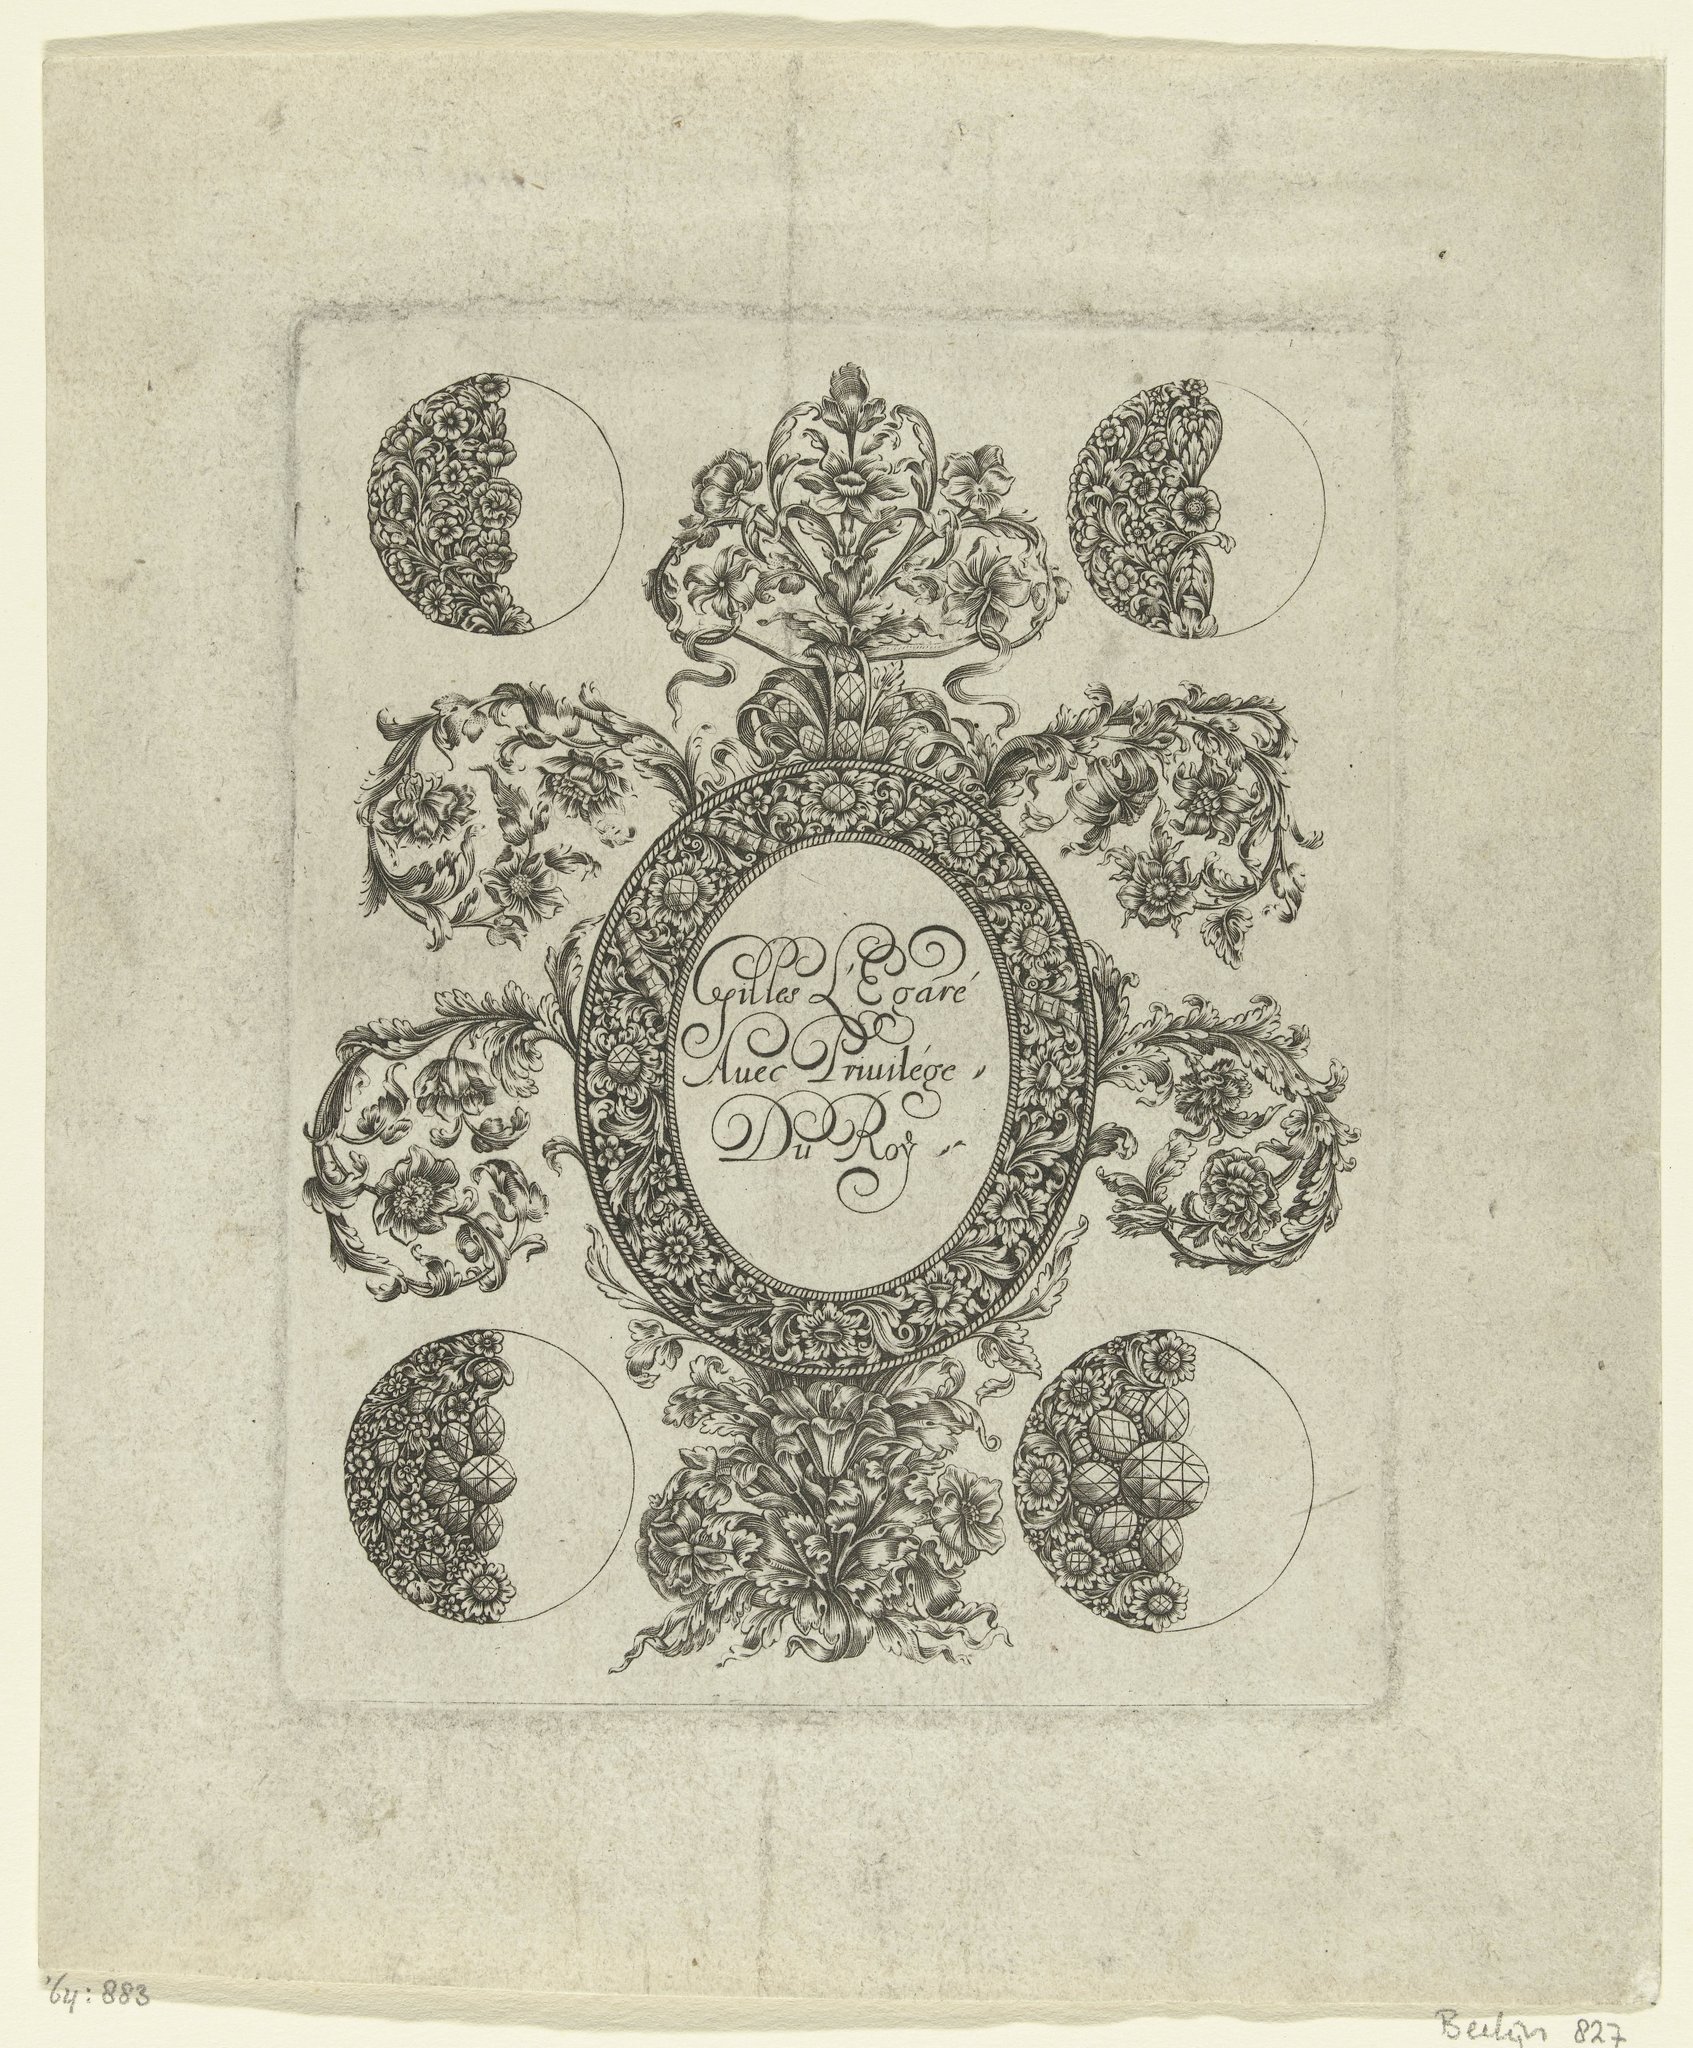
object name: print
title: Ovale rand omringd door vier horlogekasten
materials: paper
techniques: engraving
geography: paris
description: Ovale rand versierd met bloemen, bladeren en linten, waaraan zes ranken of omwikkelde bladranken vastzitten. In de hoeken vier horlogekasten. Blad 1 uit tweede serie met ontwerpen voor juwelen bestaande uit 6 bladen.